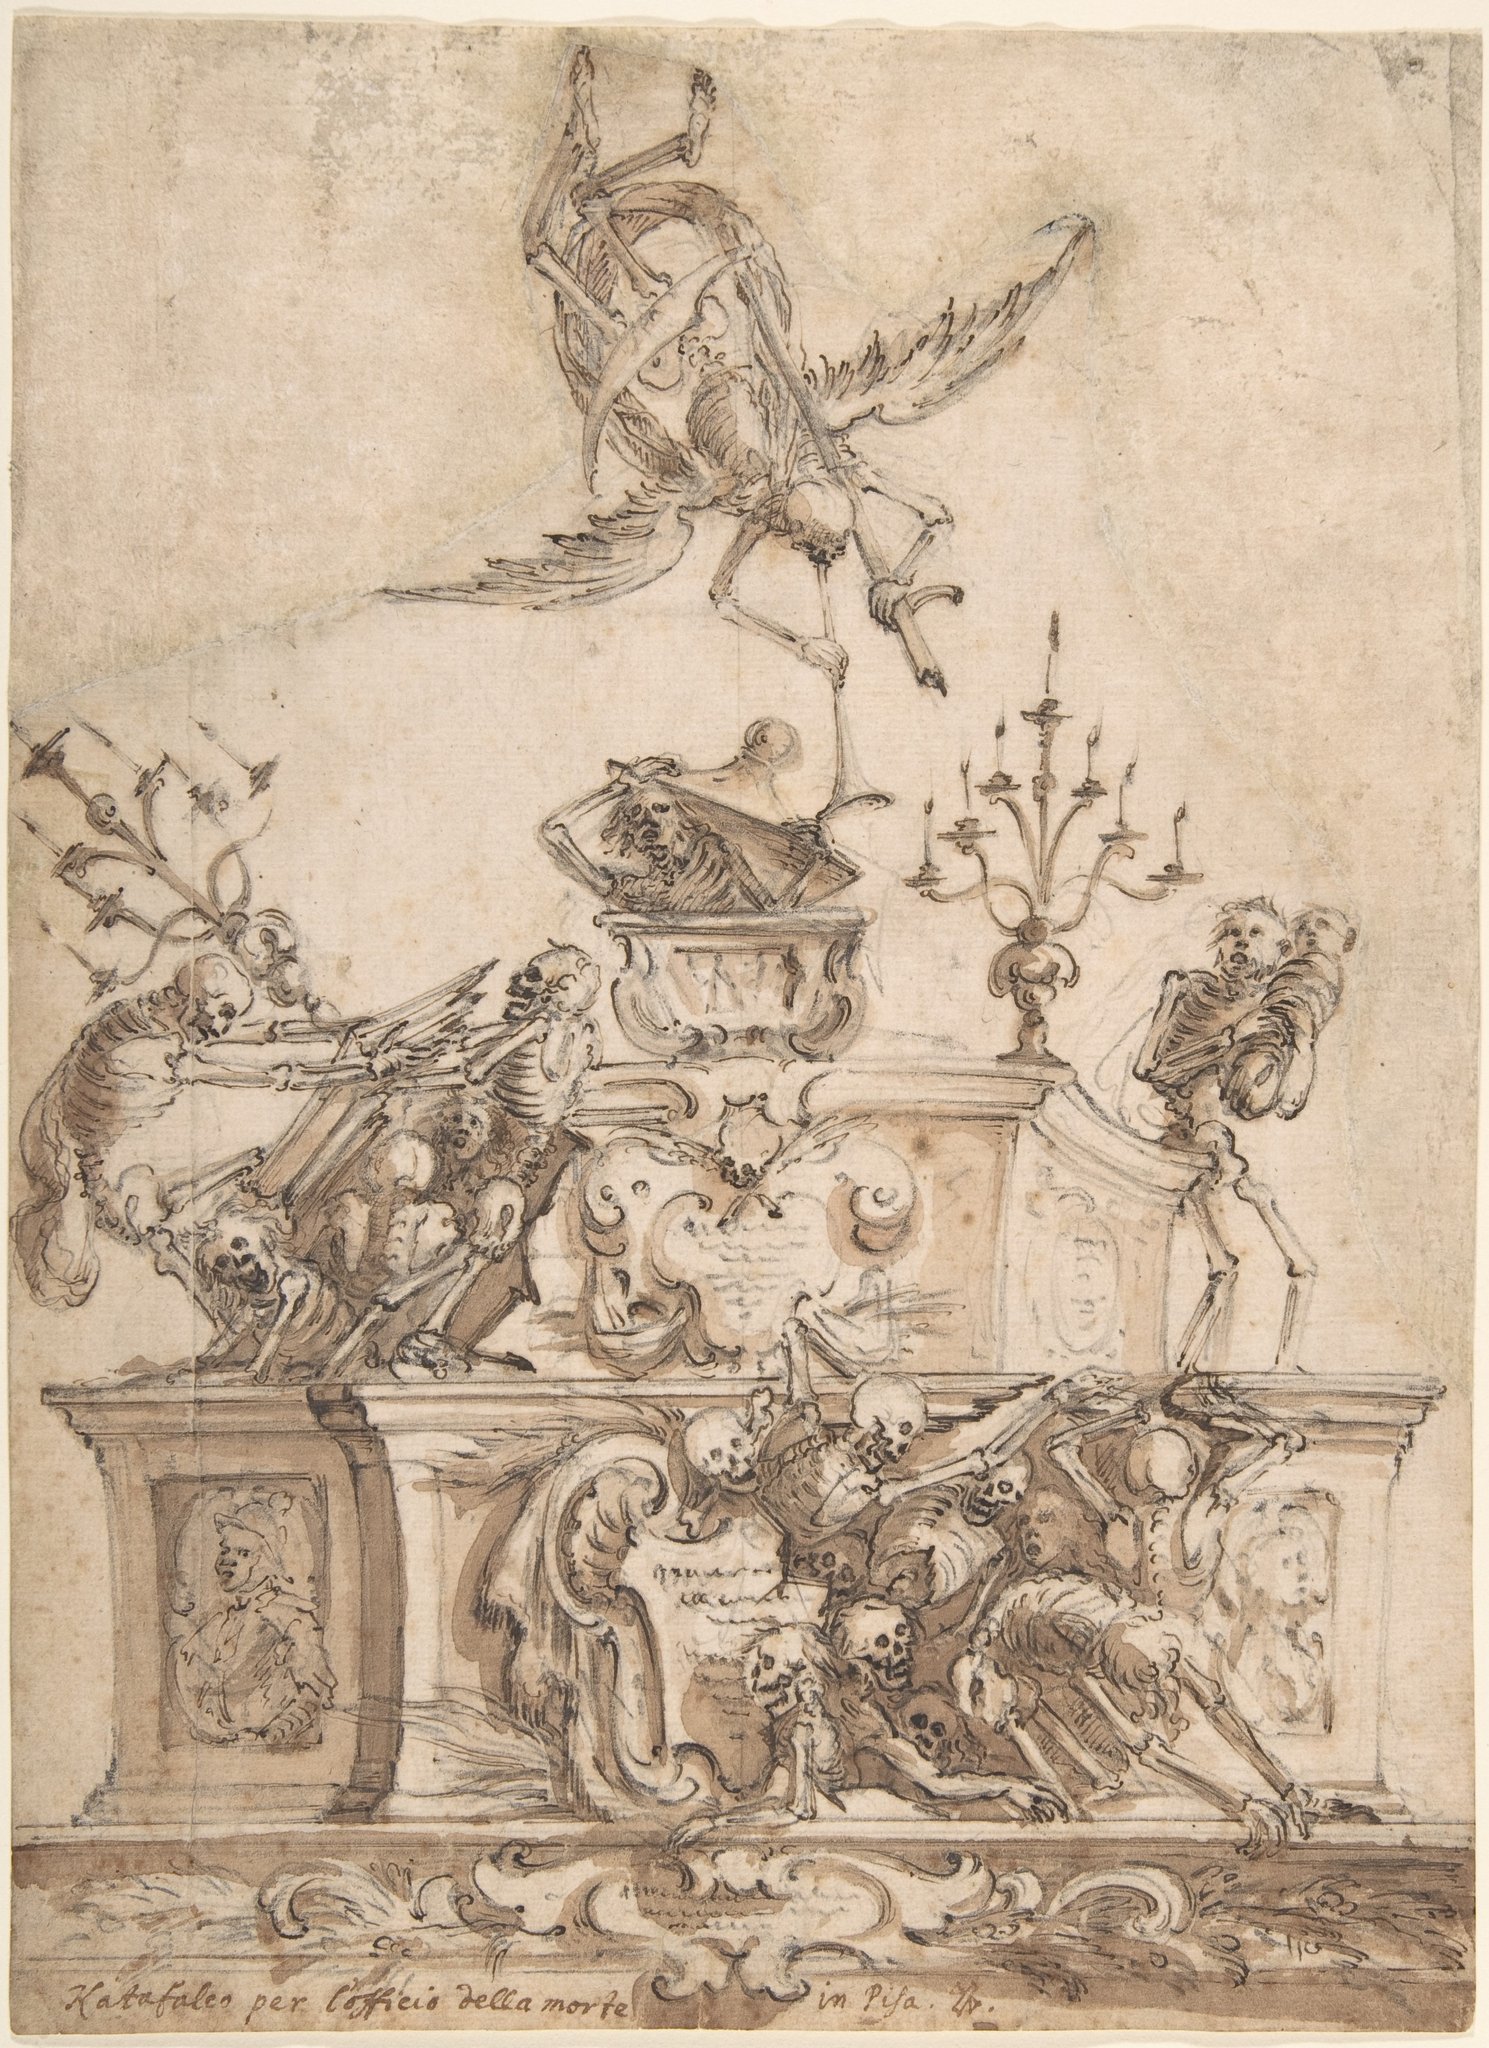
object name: drawing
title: Catafalque for funeral in Pisa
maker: anonymous, italian, 17th century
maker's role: artist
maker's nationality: italian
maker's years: 1600-1700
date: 1740-1760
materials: ink, pencil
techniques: pen, wash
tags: skeletons